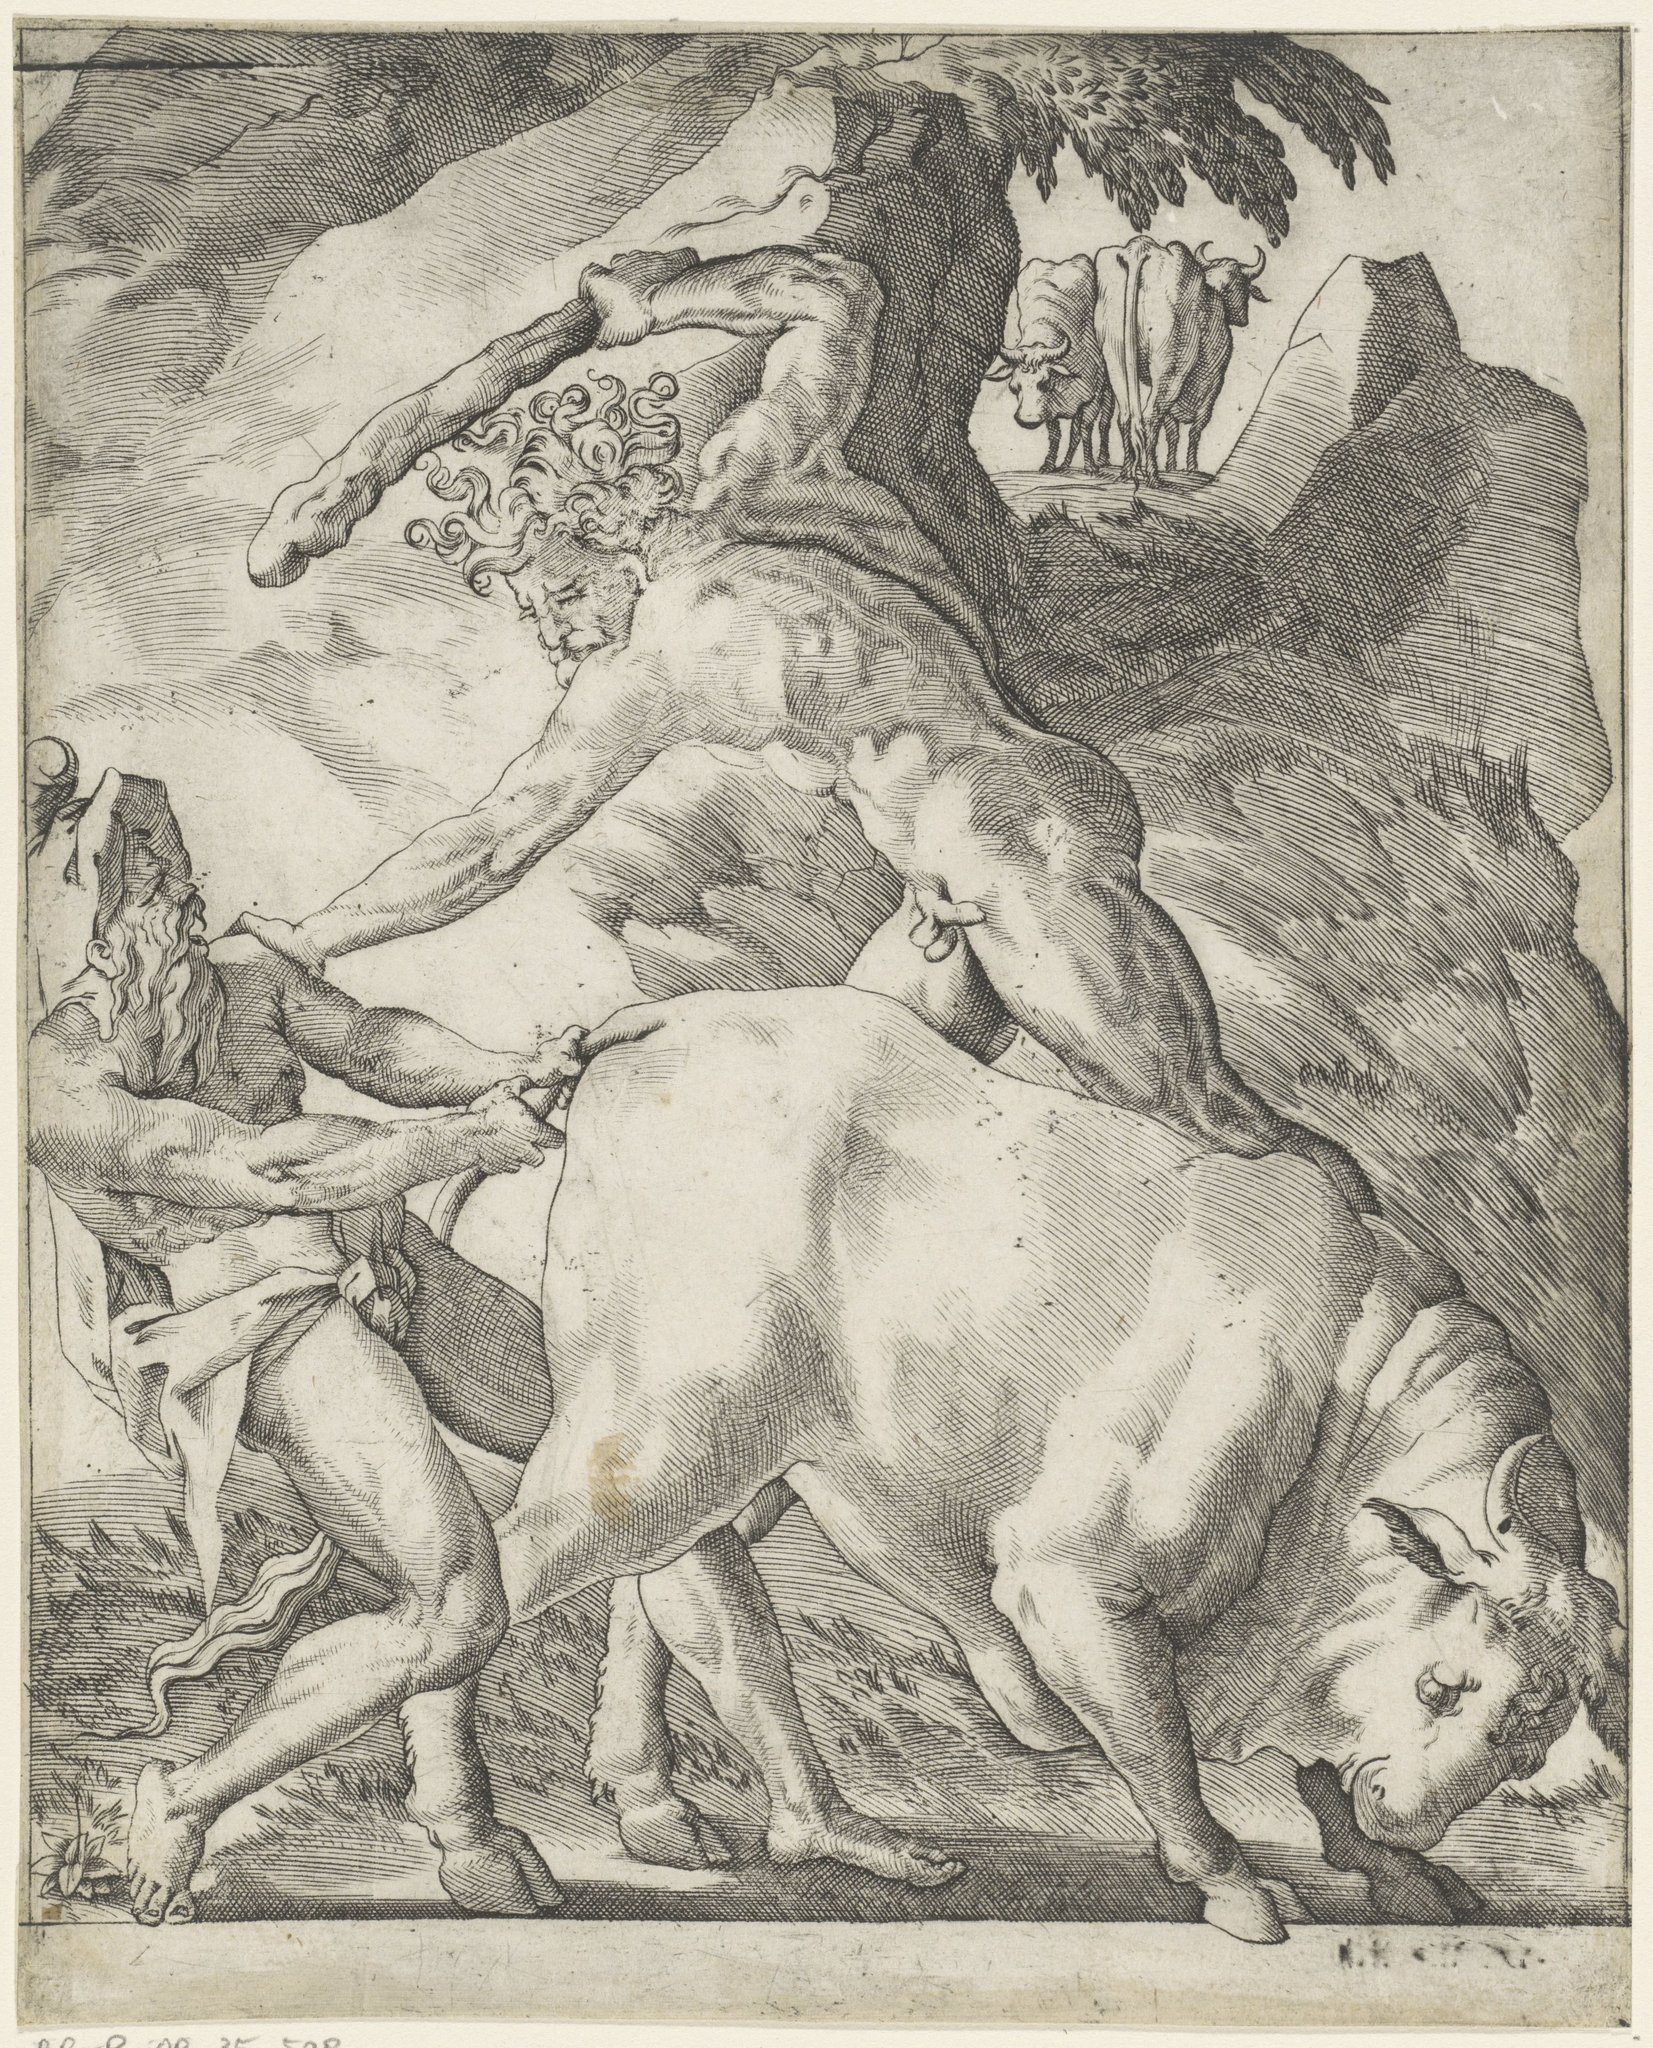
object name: print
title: Hercules vecht met Cacus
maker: giovanni jacopo caraglio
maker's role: goldsmith, print maker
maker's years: 1500-1565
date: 1515-1565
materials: paper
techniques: engraving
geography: italy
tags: cacus, the fire-breathing monster is killed in his cave by hercules, cacus steals some of the cattle of geryon which hercules was driving home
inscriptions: collector's mark: Lugt 240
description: Hercules staat met geheven knots op het punt Cacus aan te vallen omdat hij de runderen van Geryon probeert te stelen. Cacus trekt aan de staart van een van de runderen.